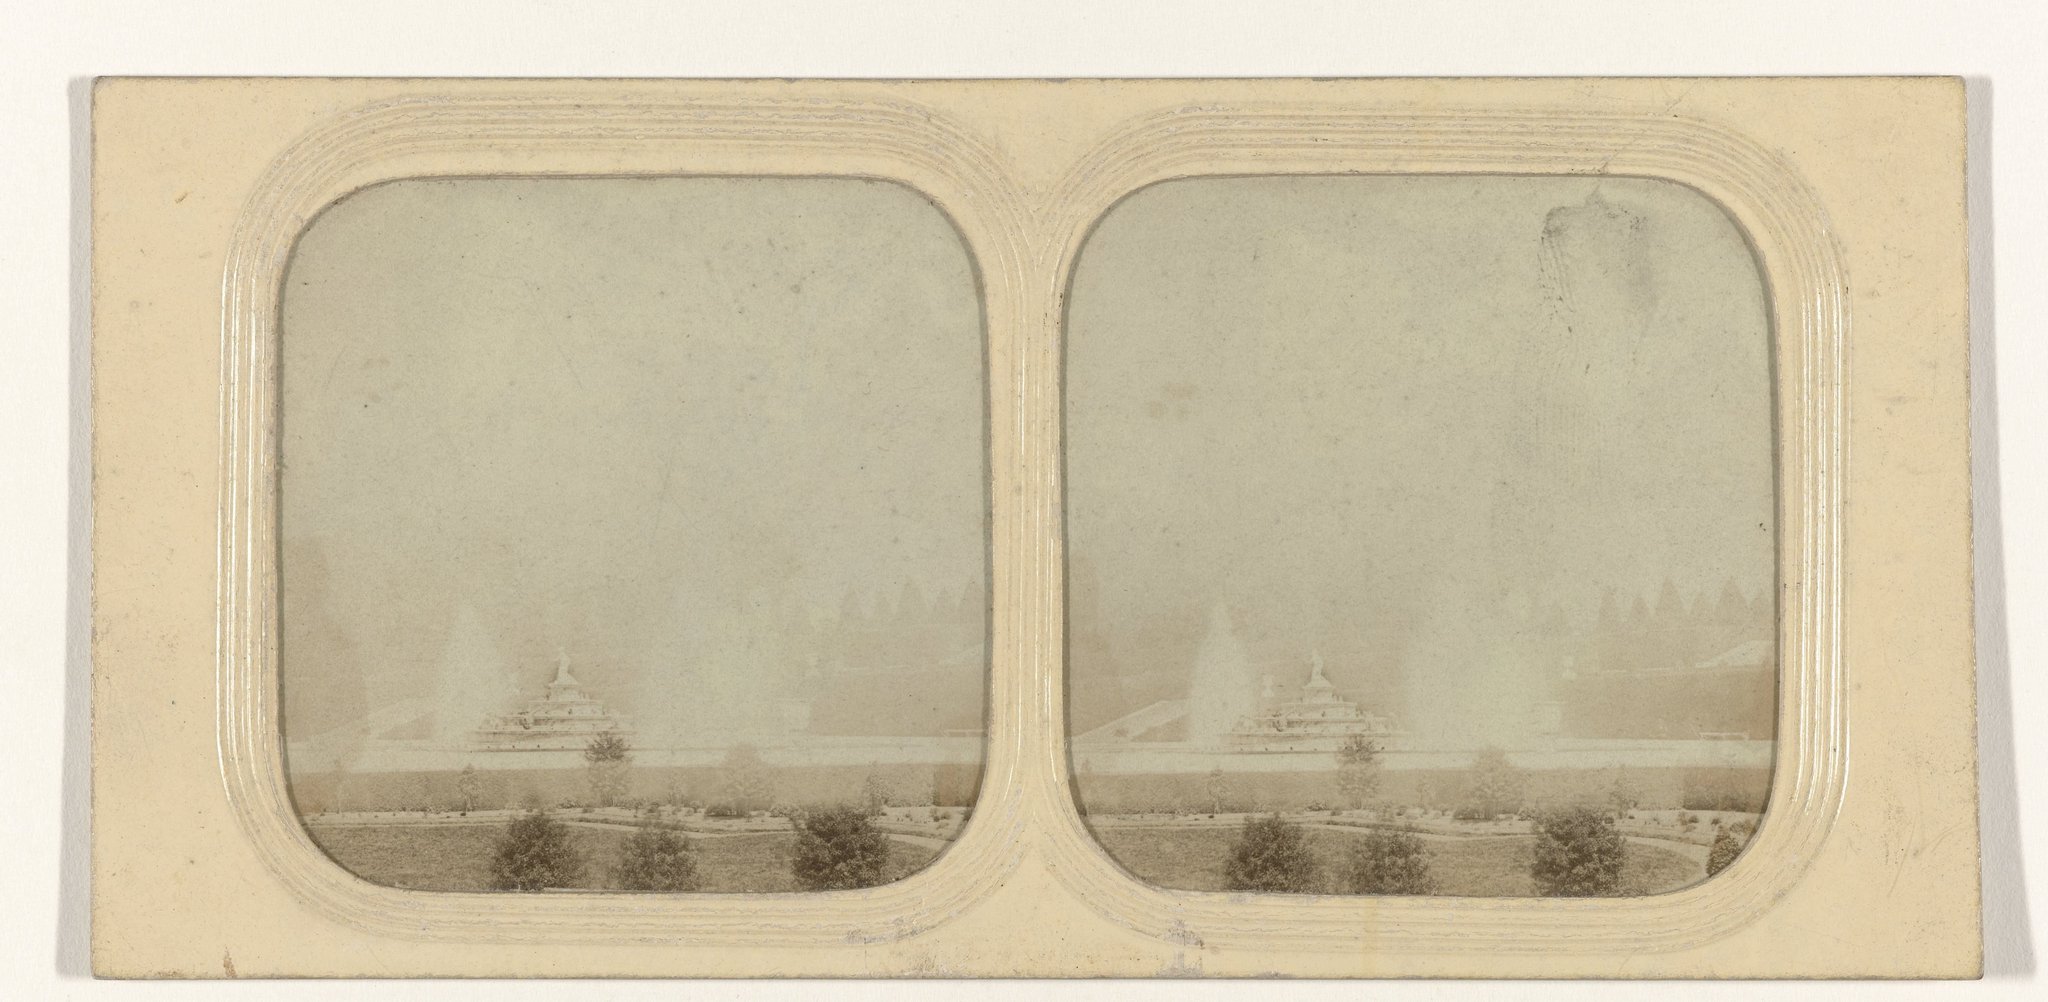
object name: stereograph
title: Gezicht op de tuin van Versailles met daarachter een gezelschap in een salon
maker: Anonymous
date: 1855-1875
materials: cardboard, paper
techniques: albumen print, hand coloring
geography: versailles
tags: drawing-room, 'salon', french or architectonic garden; formal garden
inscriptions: number: ‘75’, inscription: ‘hs’, number: ‘60’